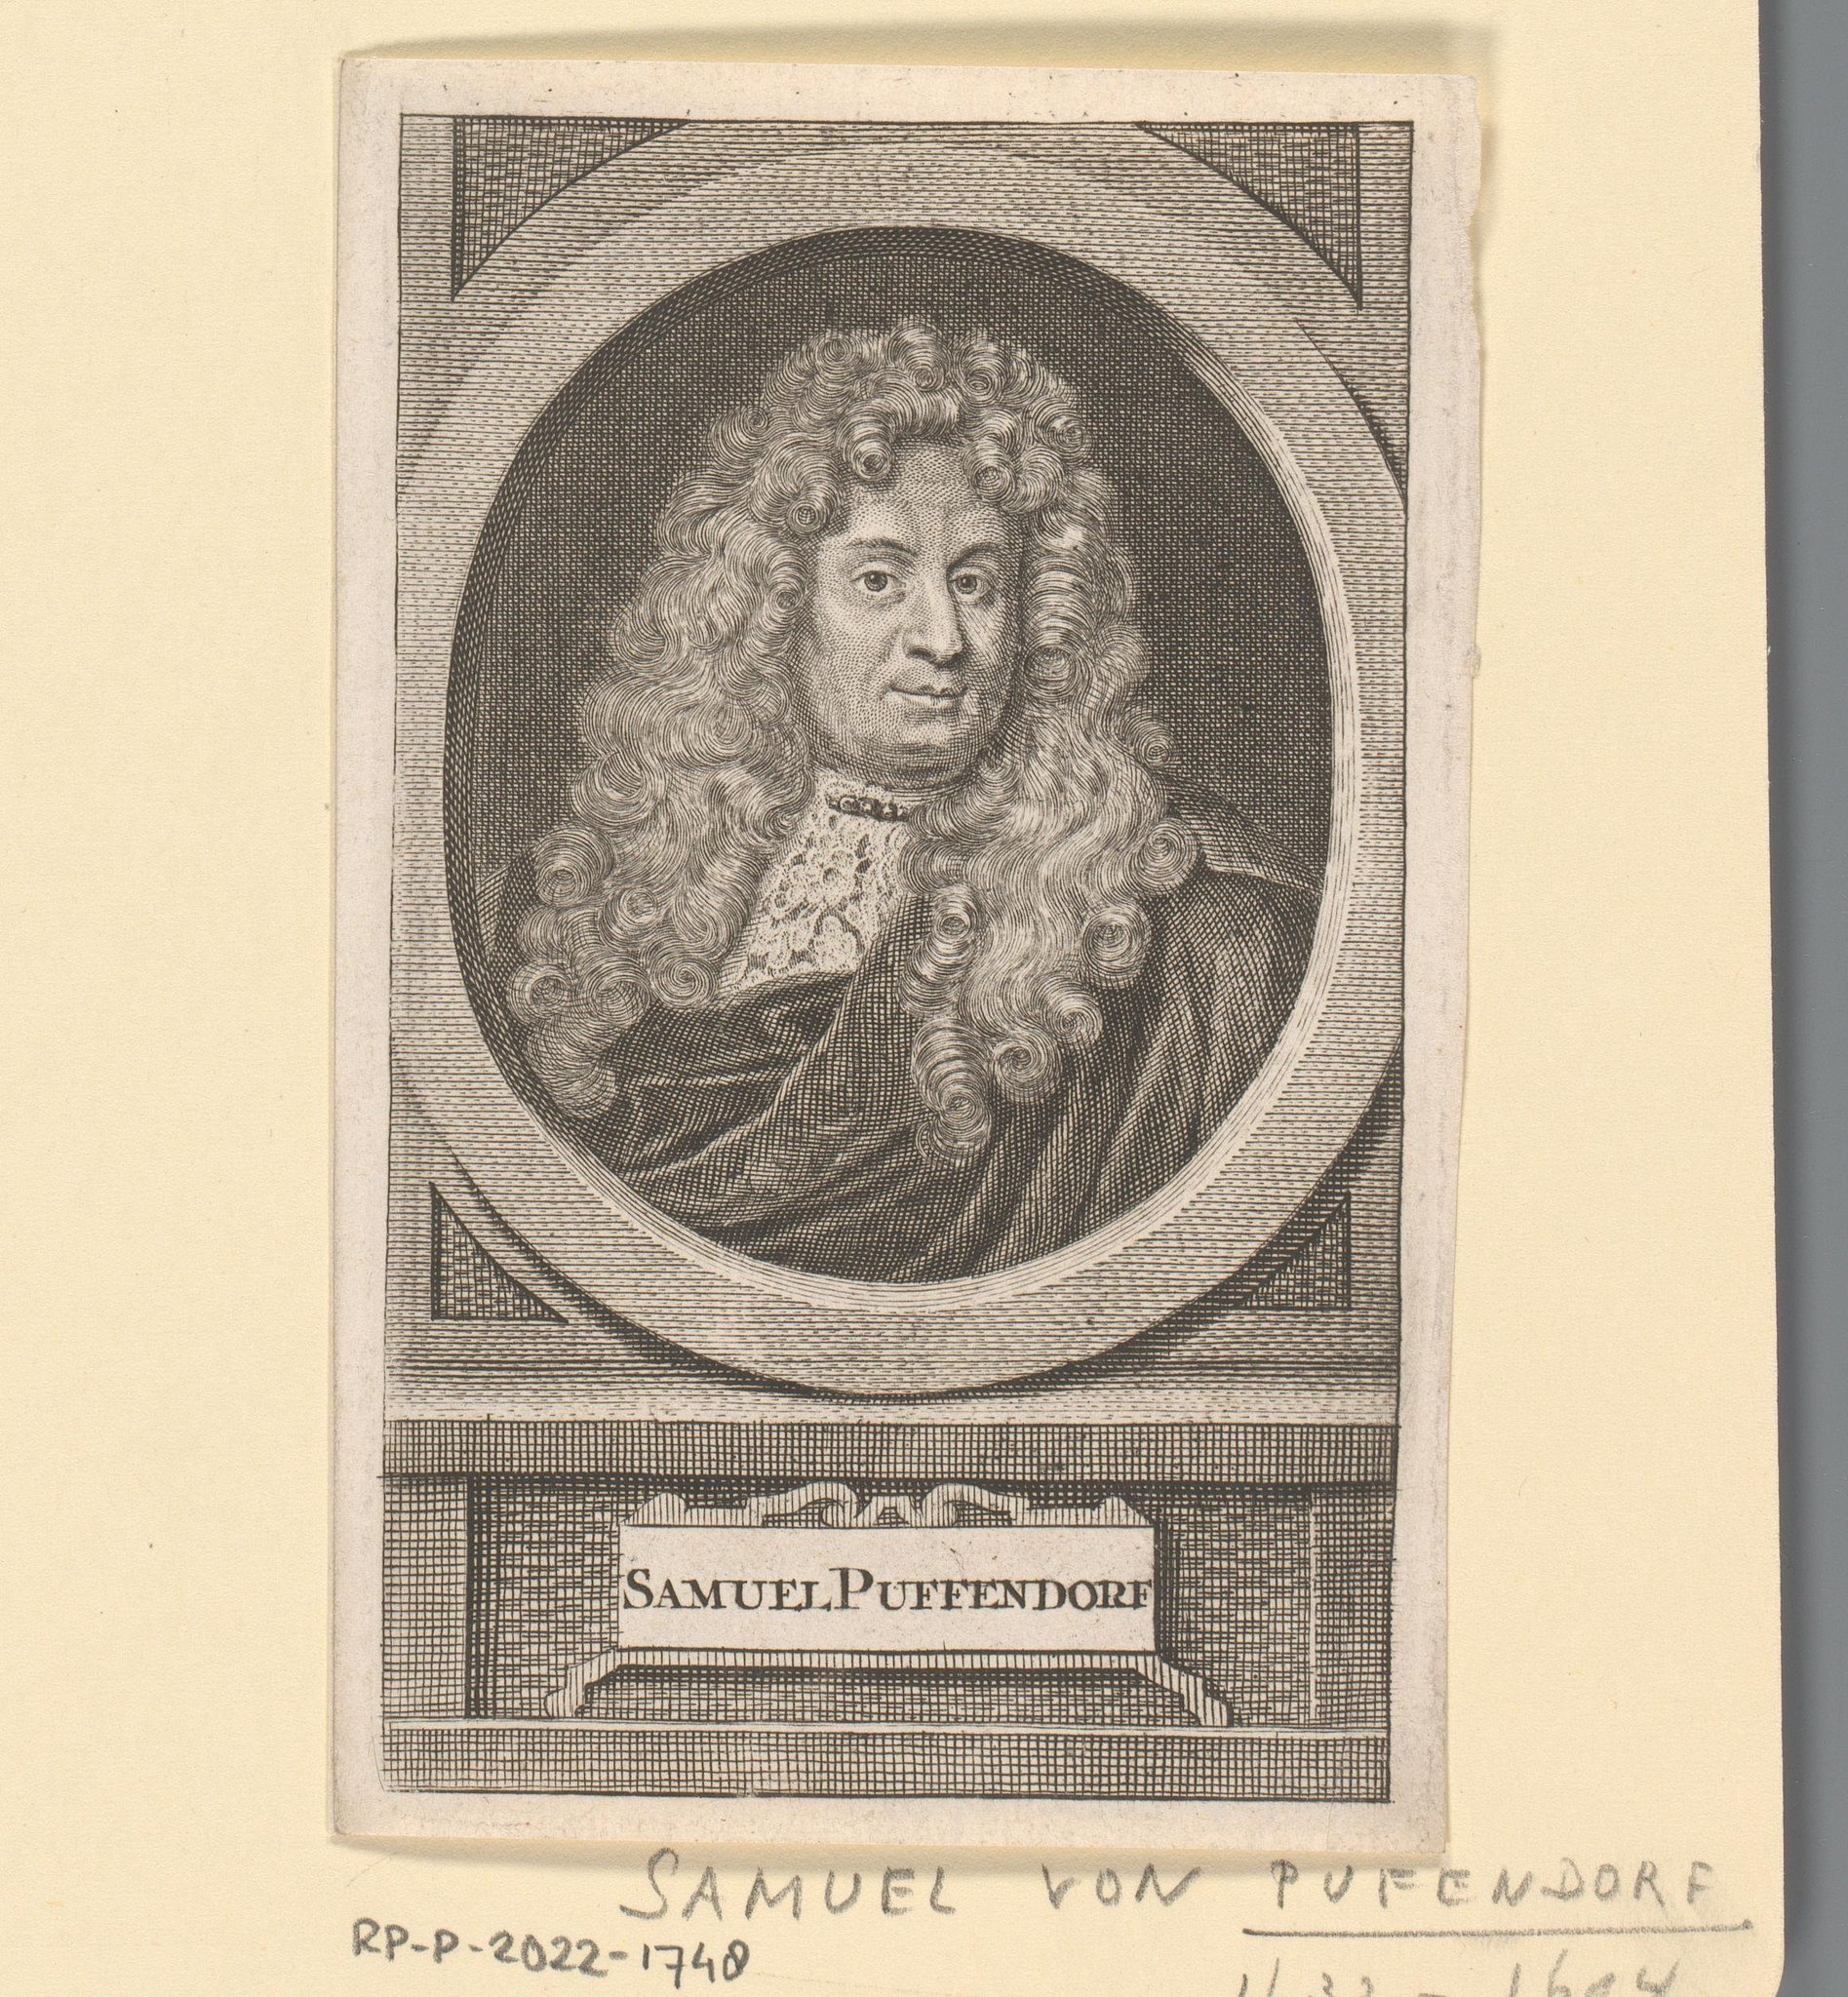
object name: print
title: Portret van Samuel von Pufendorf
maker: Anonymous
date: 1700-1799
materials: paper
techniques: engraving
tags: berlin, history and archaeology (+ portrait of scholar, scientist), scholar, philosopher, historical persons